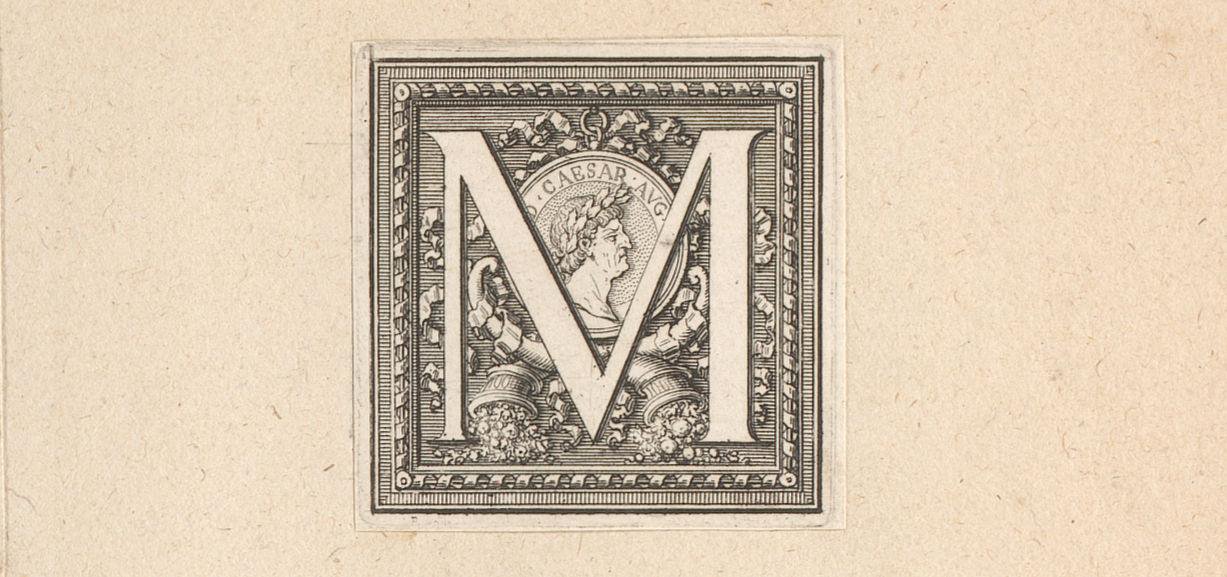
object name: print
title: Initiaal 'M' met medaille met het portret van Julius Caesar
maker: sébastien leclerc (i)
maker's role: print maker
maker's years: 1637-1714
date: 1647-1714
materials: paper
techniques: etching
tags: initial, historical persons, memorial medal